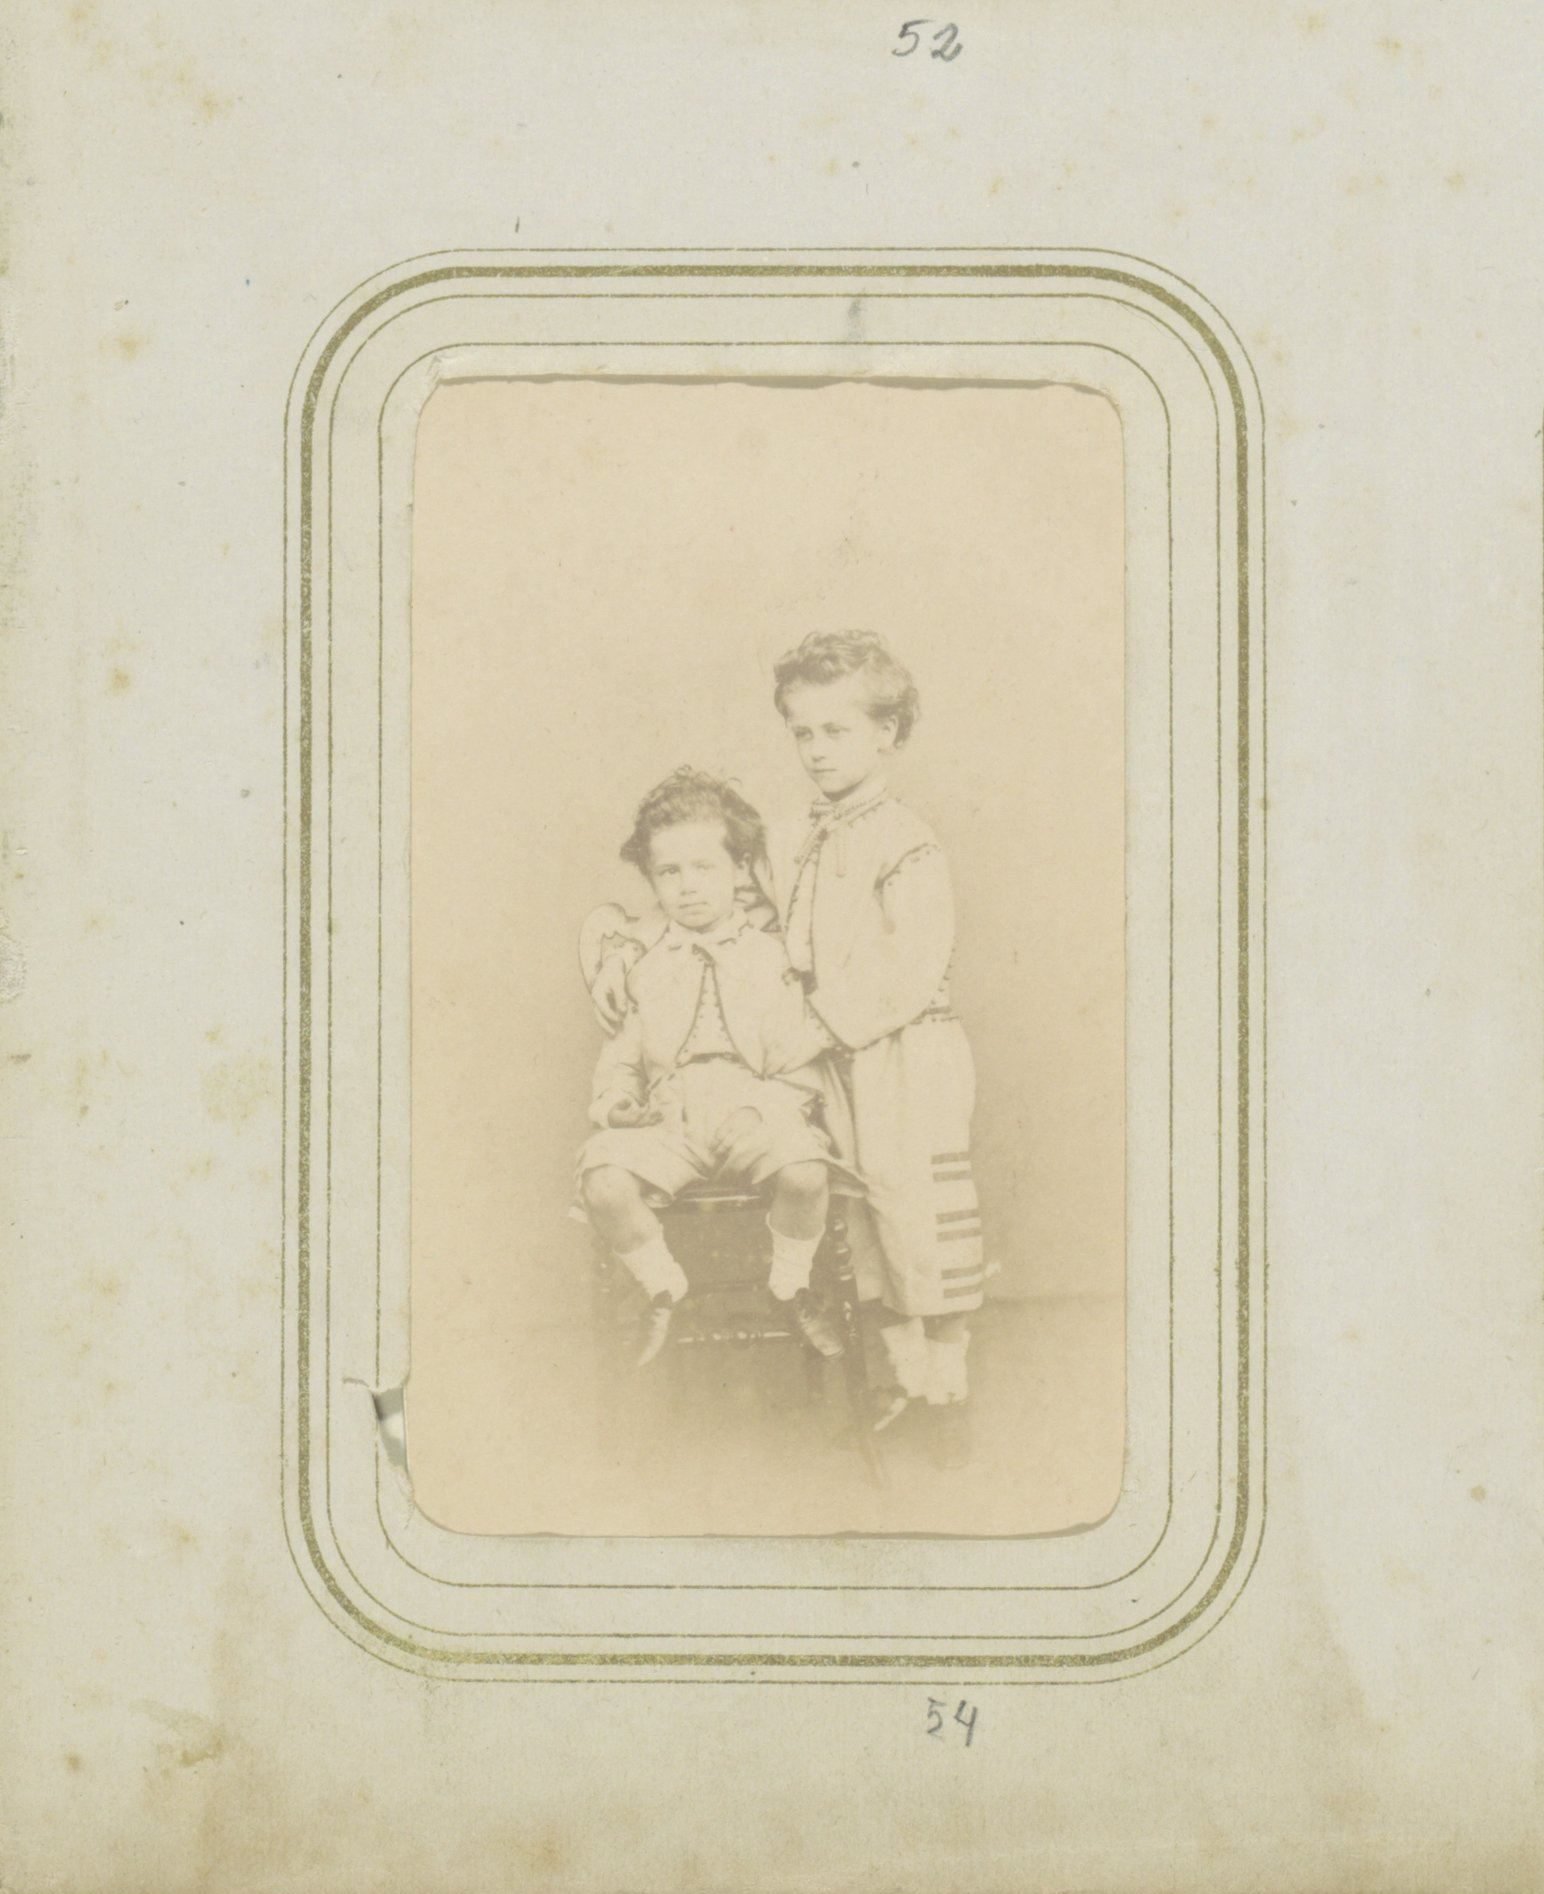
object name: carte de visite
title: Portret van twee jonge kinderen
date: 1860-1900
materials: cardboard, photographic support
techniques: albumen print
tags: studio requisites ~ photographer, trousers, breeches, child, historical persons, clothing for the upper part of the body, family, relationship, descent, hairdress, netherlands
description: Onderdeel van Familiealbum van H.W.F. Ligtenberg en L.M. Swart met 149 foto's en cartes-de-visite.